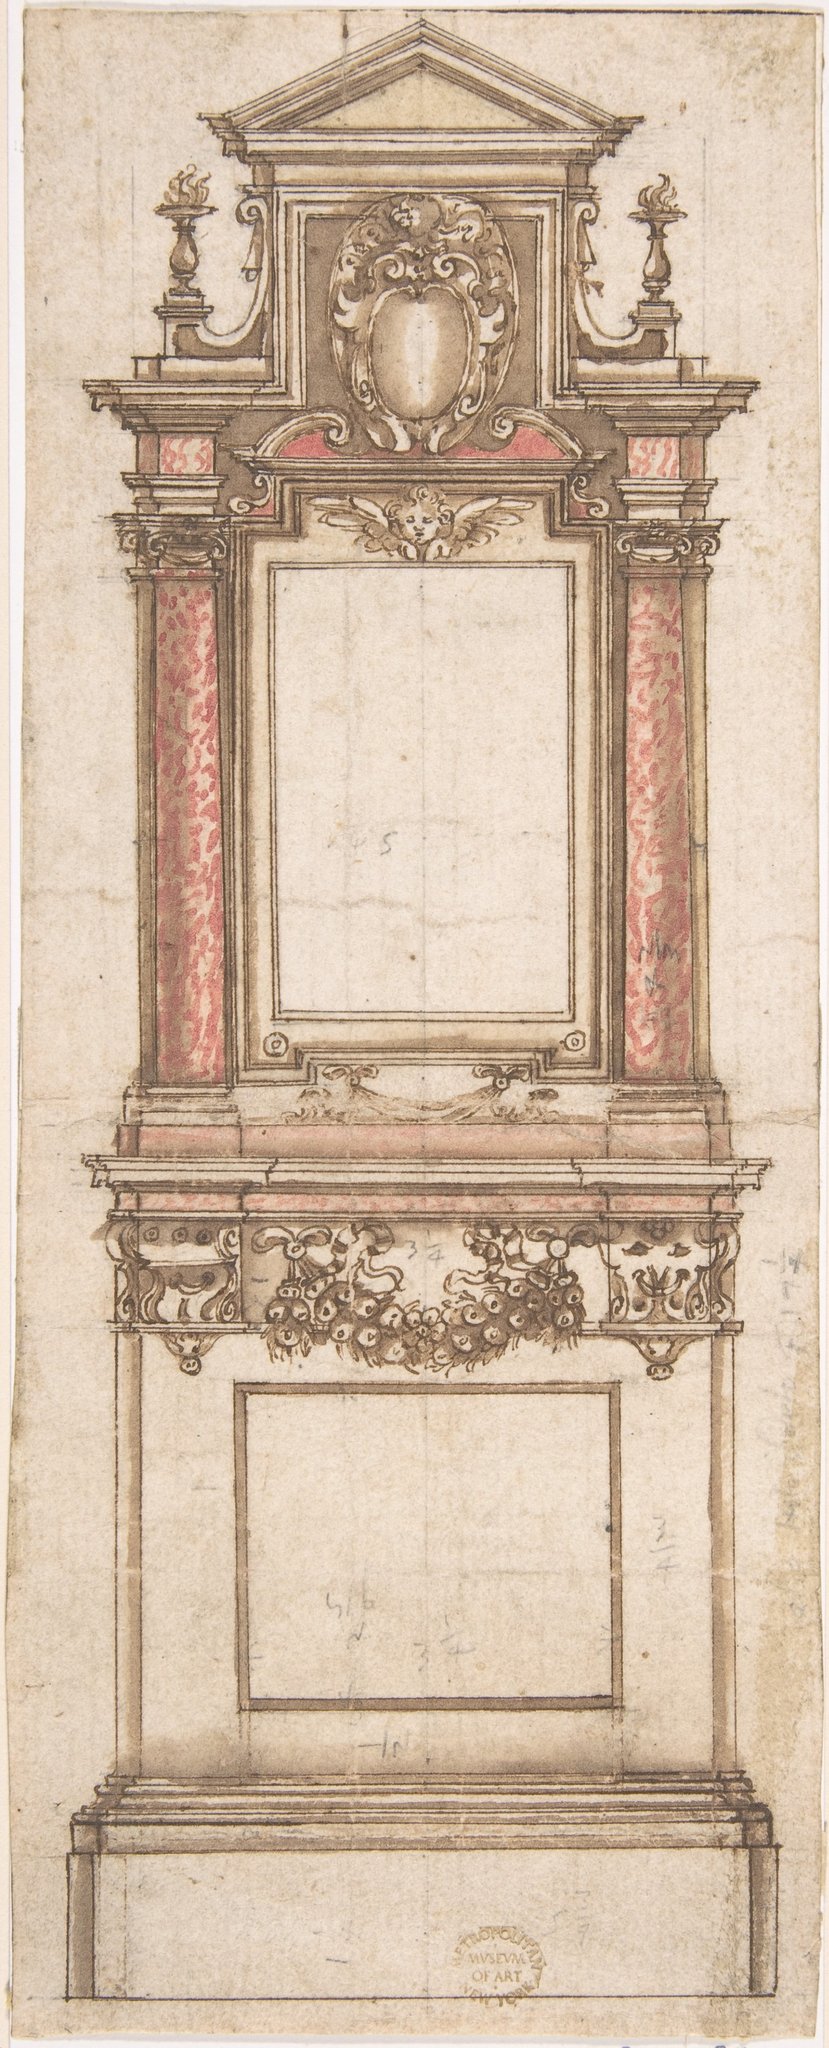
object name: drawing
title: Frame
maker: anonymous, italian, 16th century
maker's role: artist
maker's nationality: italian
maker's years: 1550-1600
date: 1501-1600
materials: ink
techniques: pen, wash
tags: architecture